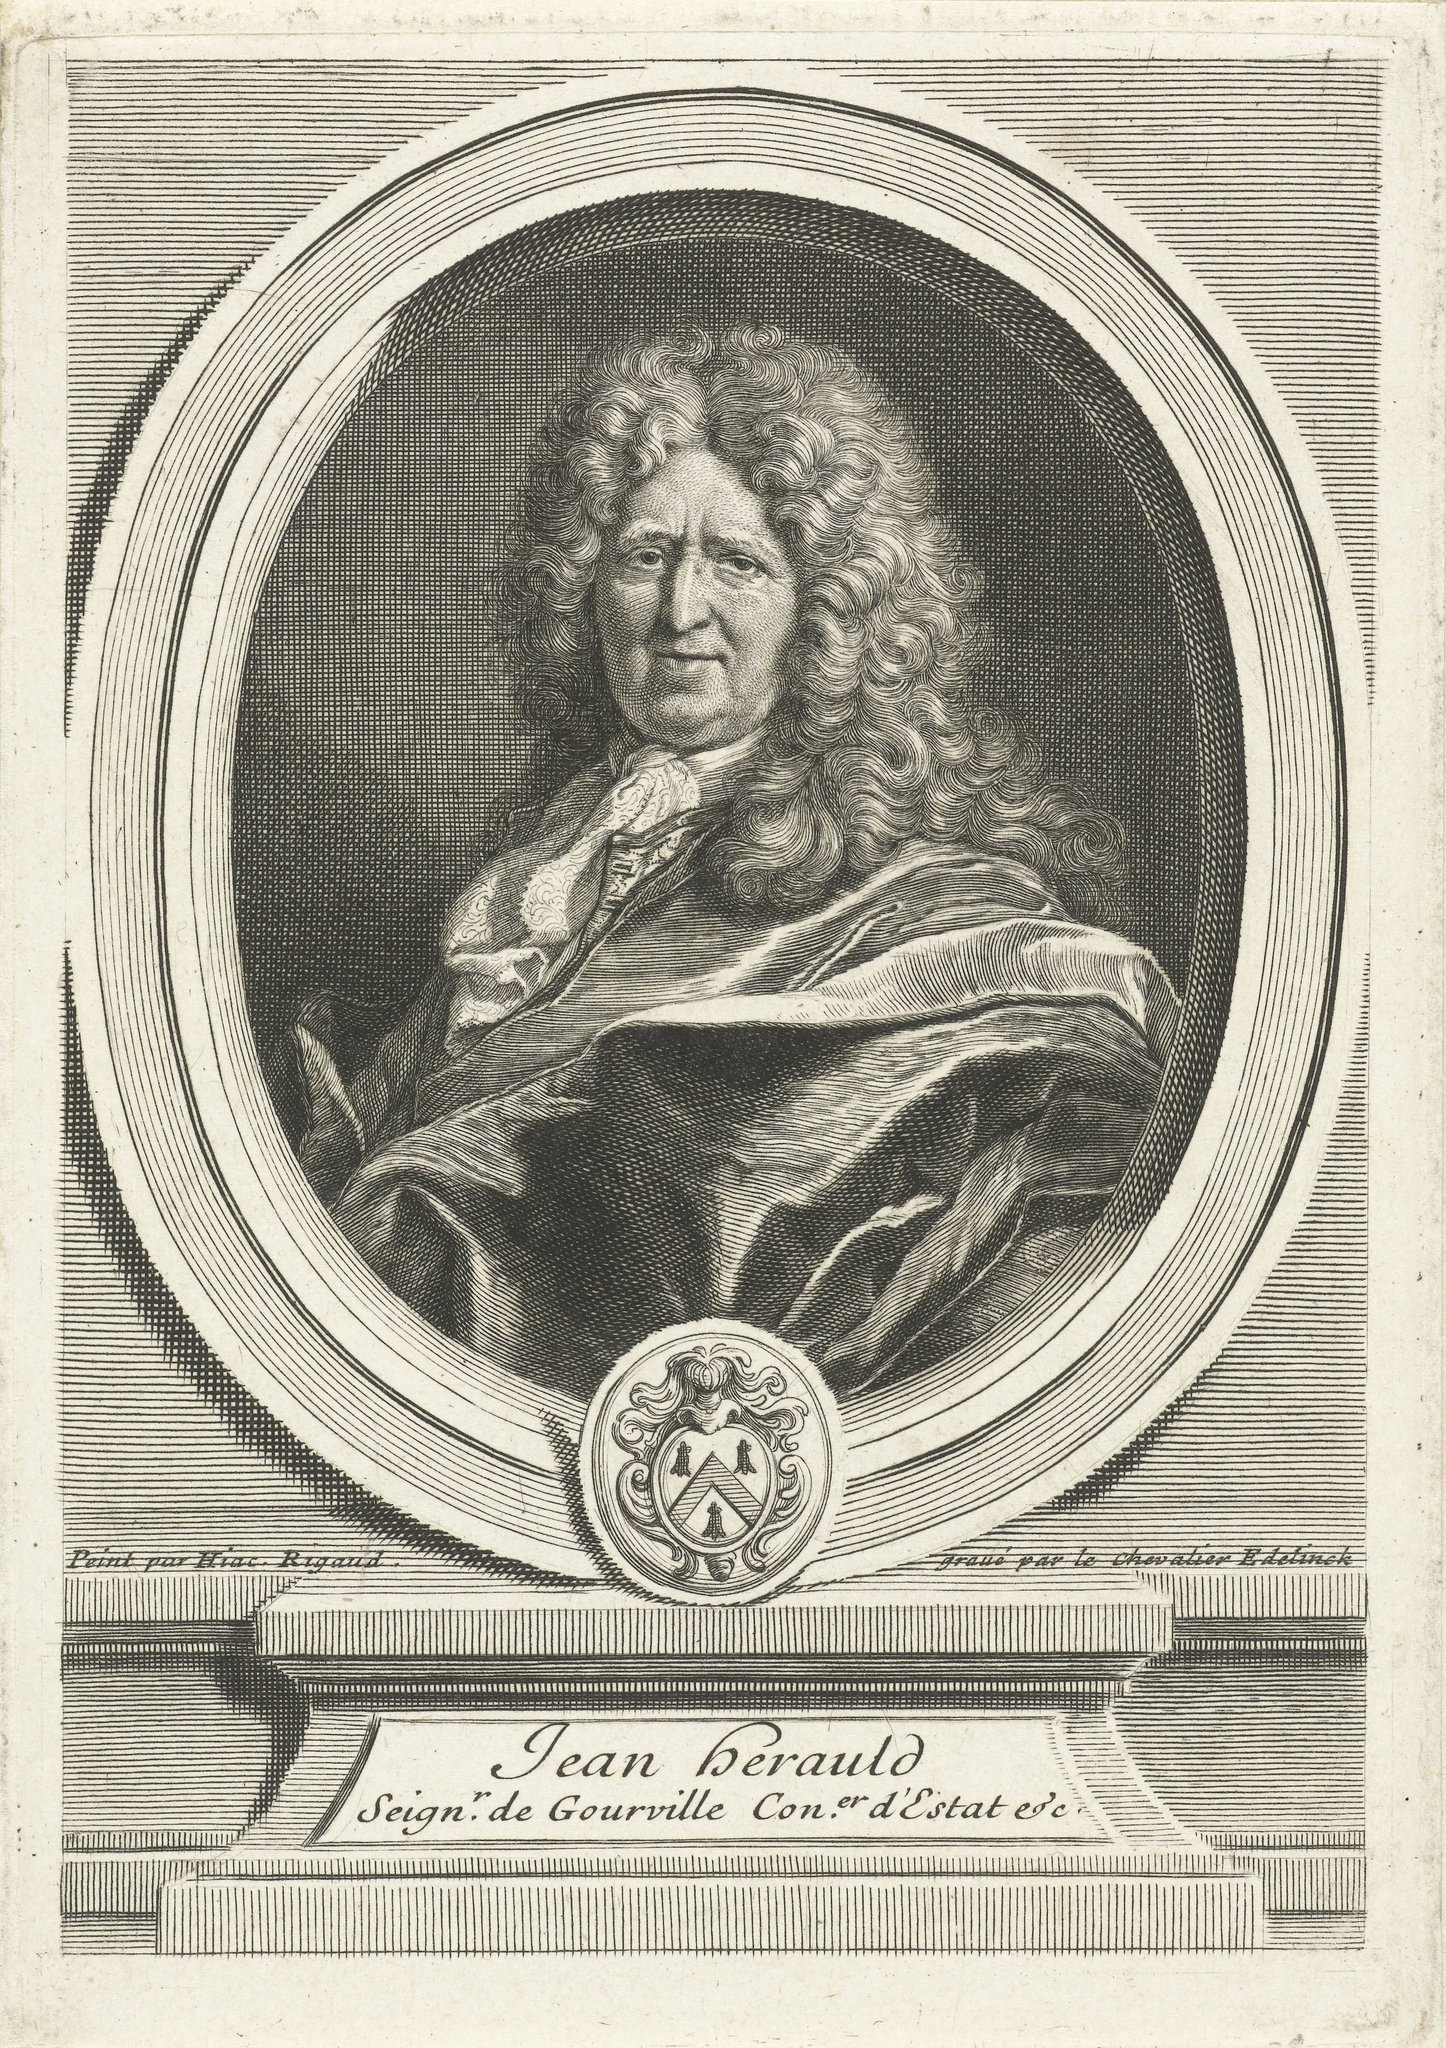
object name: print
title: Portret van Jean Hérault de Gourville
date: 1669-1707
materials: paper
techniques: engraving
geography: france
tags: jean hérault de gourville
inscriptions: collector's mark: Lugt 2228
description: Portret van de Franse diplomaat Jean Hérault de Gourville (1625-1703), afgebeeld in ovale omlijsting met wapen.